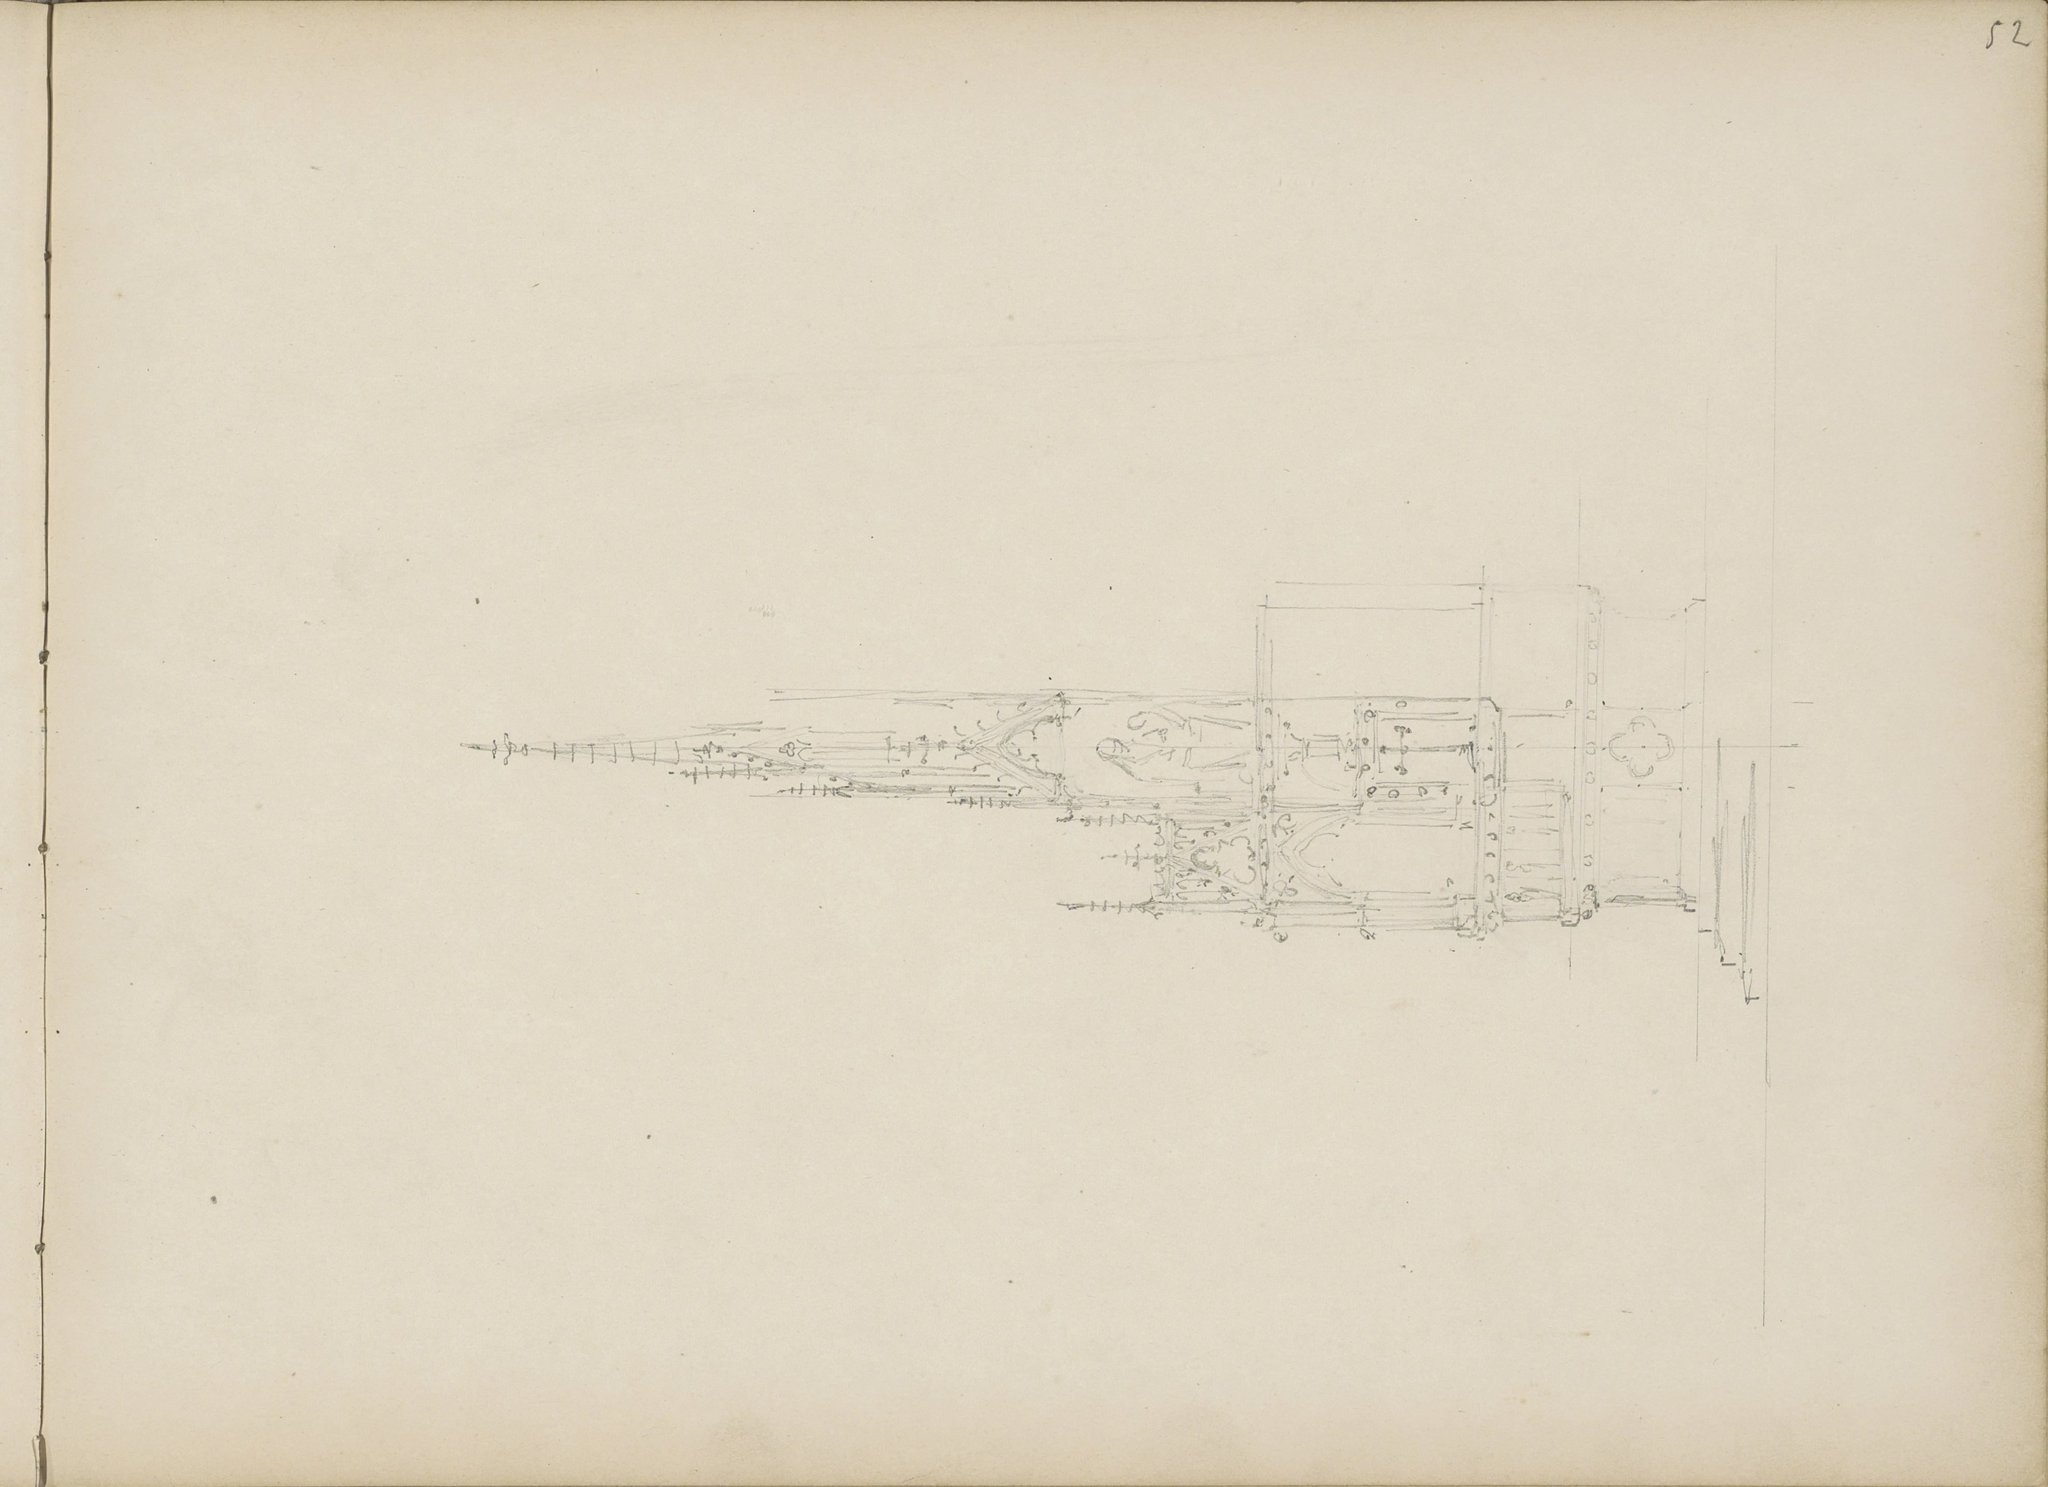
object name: sketchbook leaf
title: Altaar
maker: pierre joseph hubert cuypers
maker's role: draughtsman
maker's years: 1827-1921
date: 1857-1859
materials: paper, pencil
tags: altar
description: Blad 52 recto uit een schetsboek met 77 bladen.